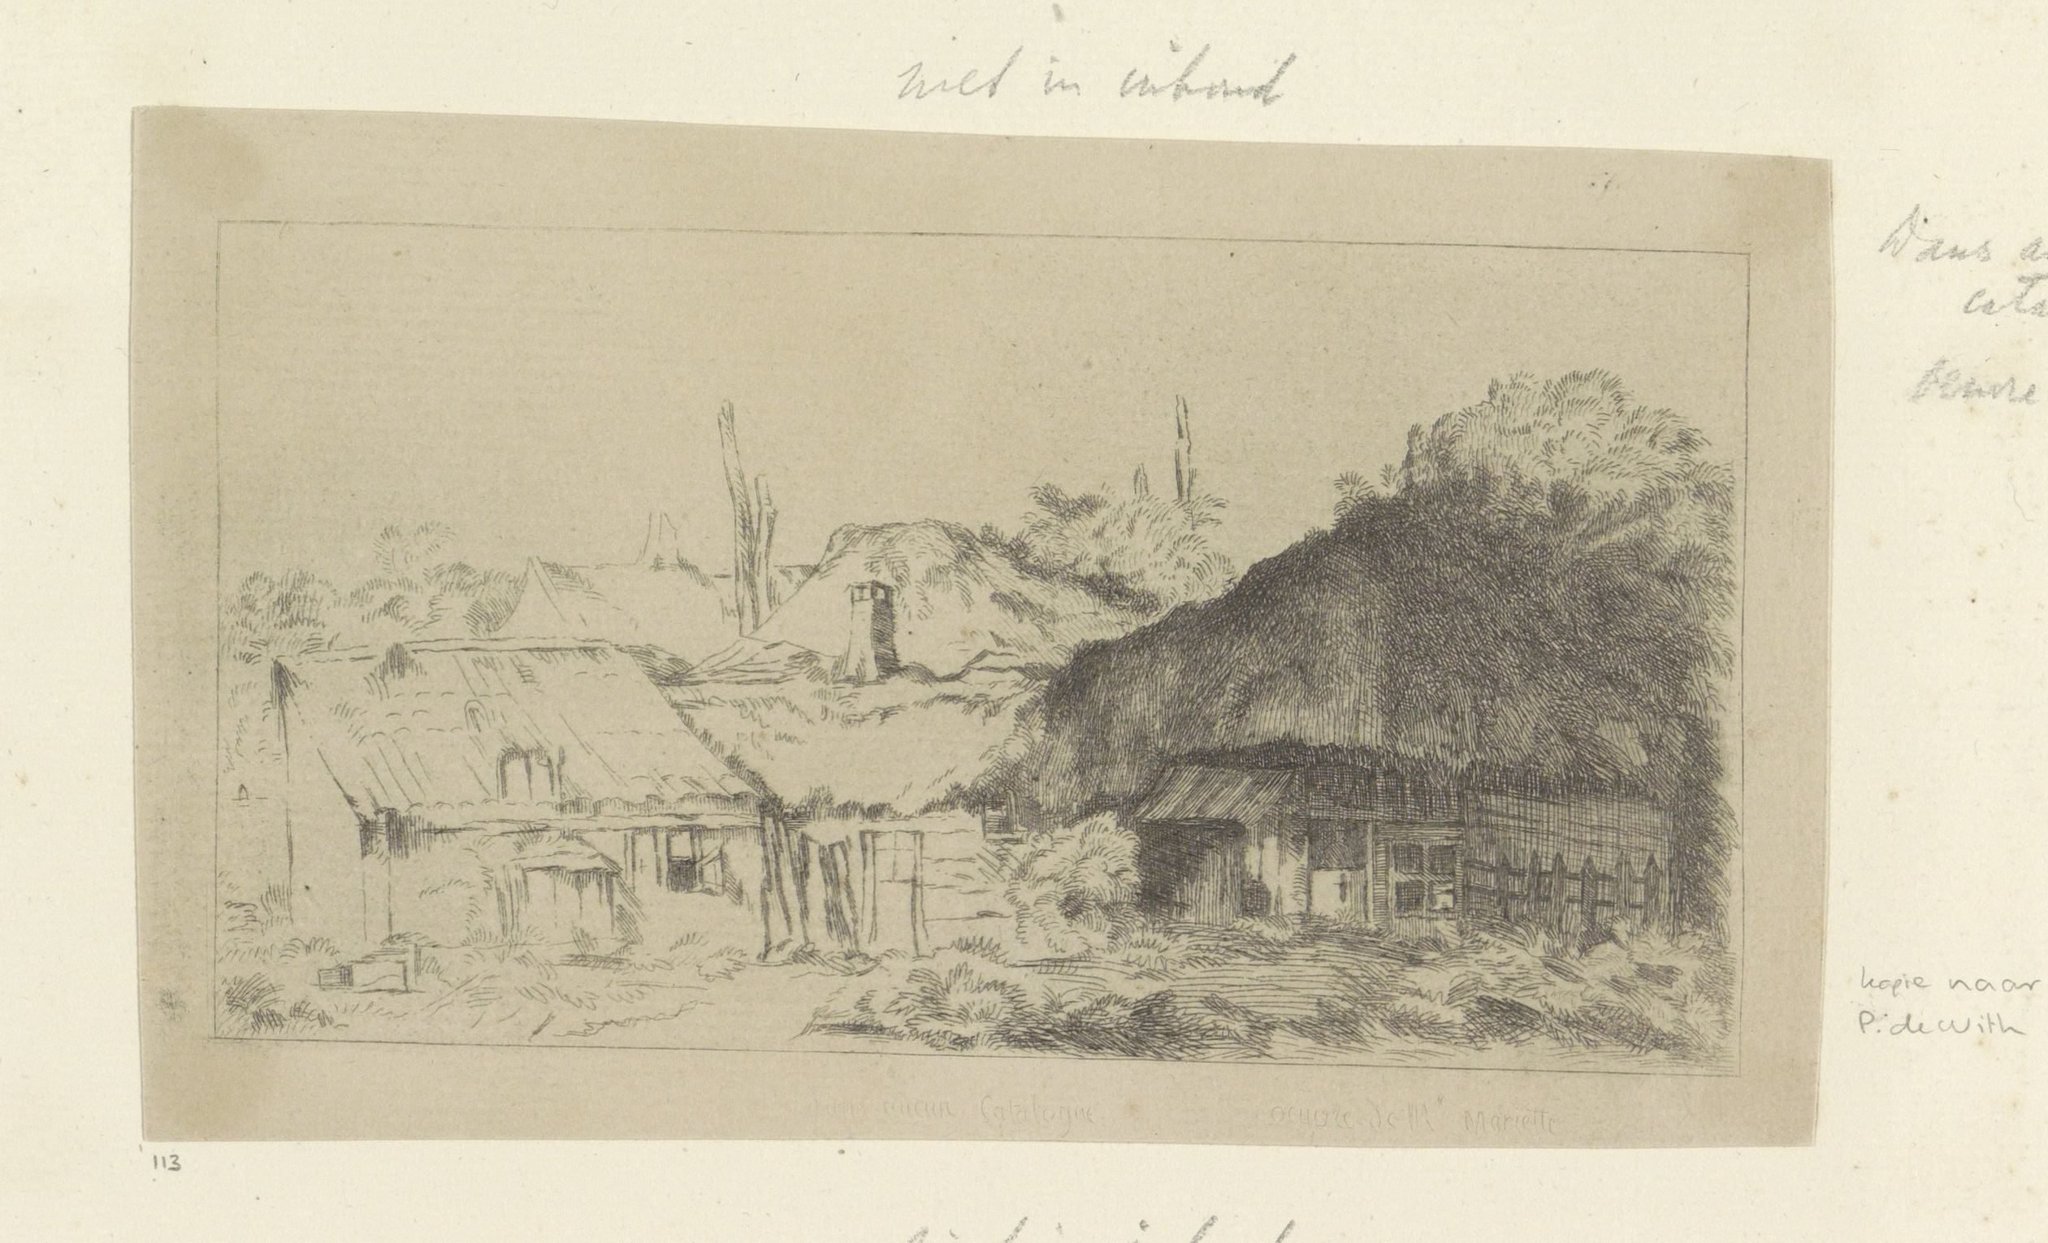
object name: kopie naar prent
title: Boerderij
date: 1750-1797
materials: paper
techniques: etching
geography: paris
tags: farm or solitary house in landscape